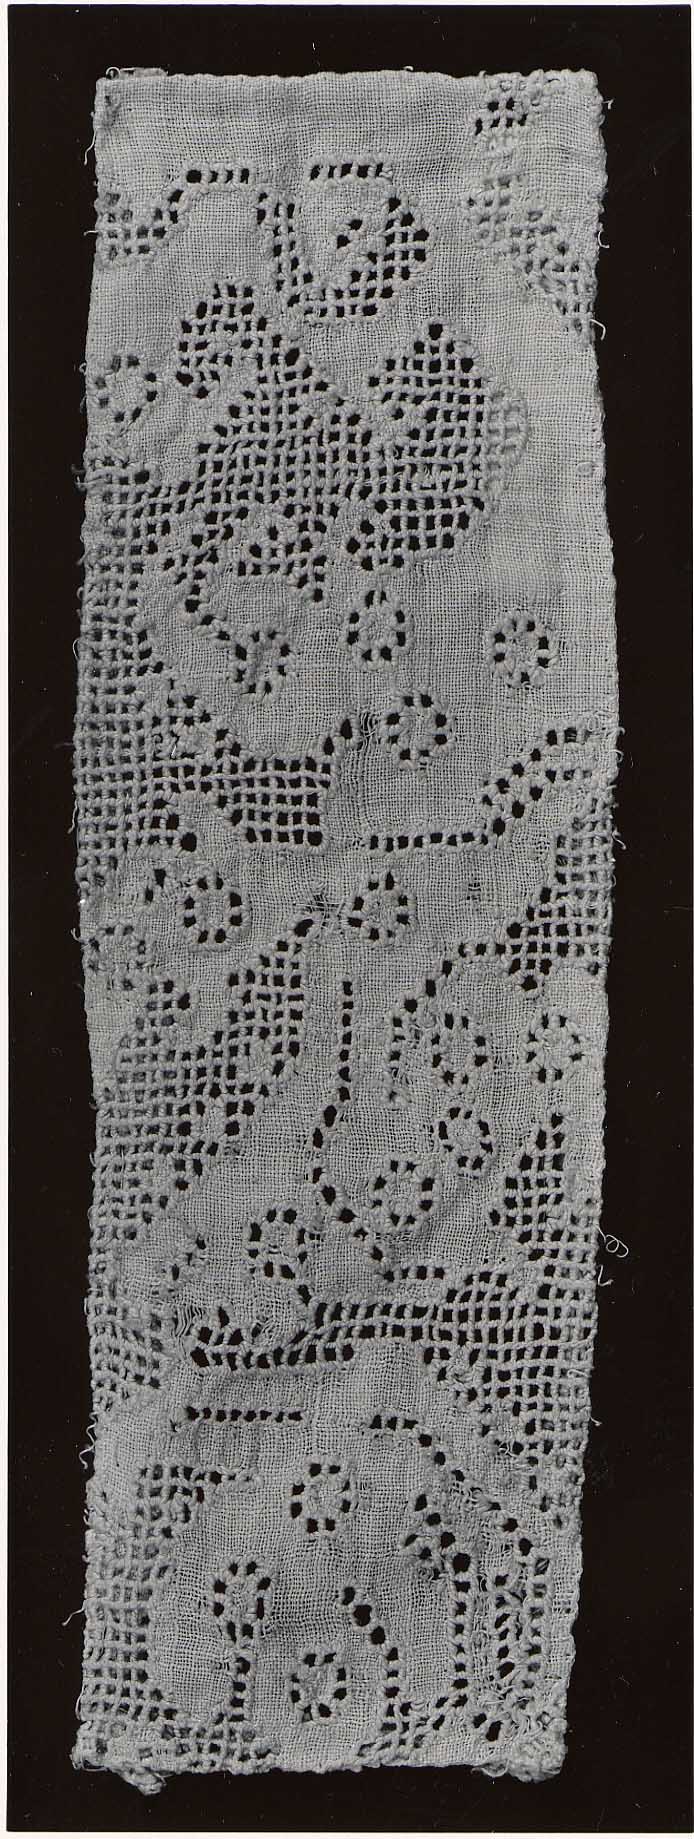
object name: textile border fragment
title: Border Fragment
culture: italian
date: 1601-1700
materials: linen